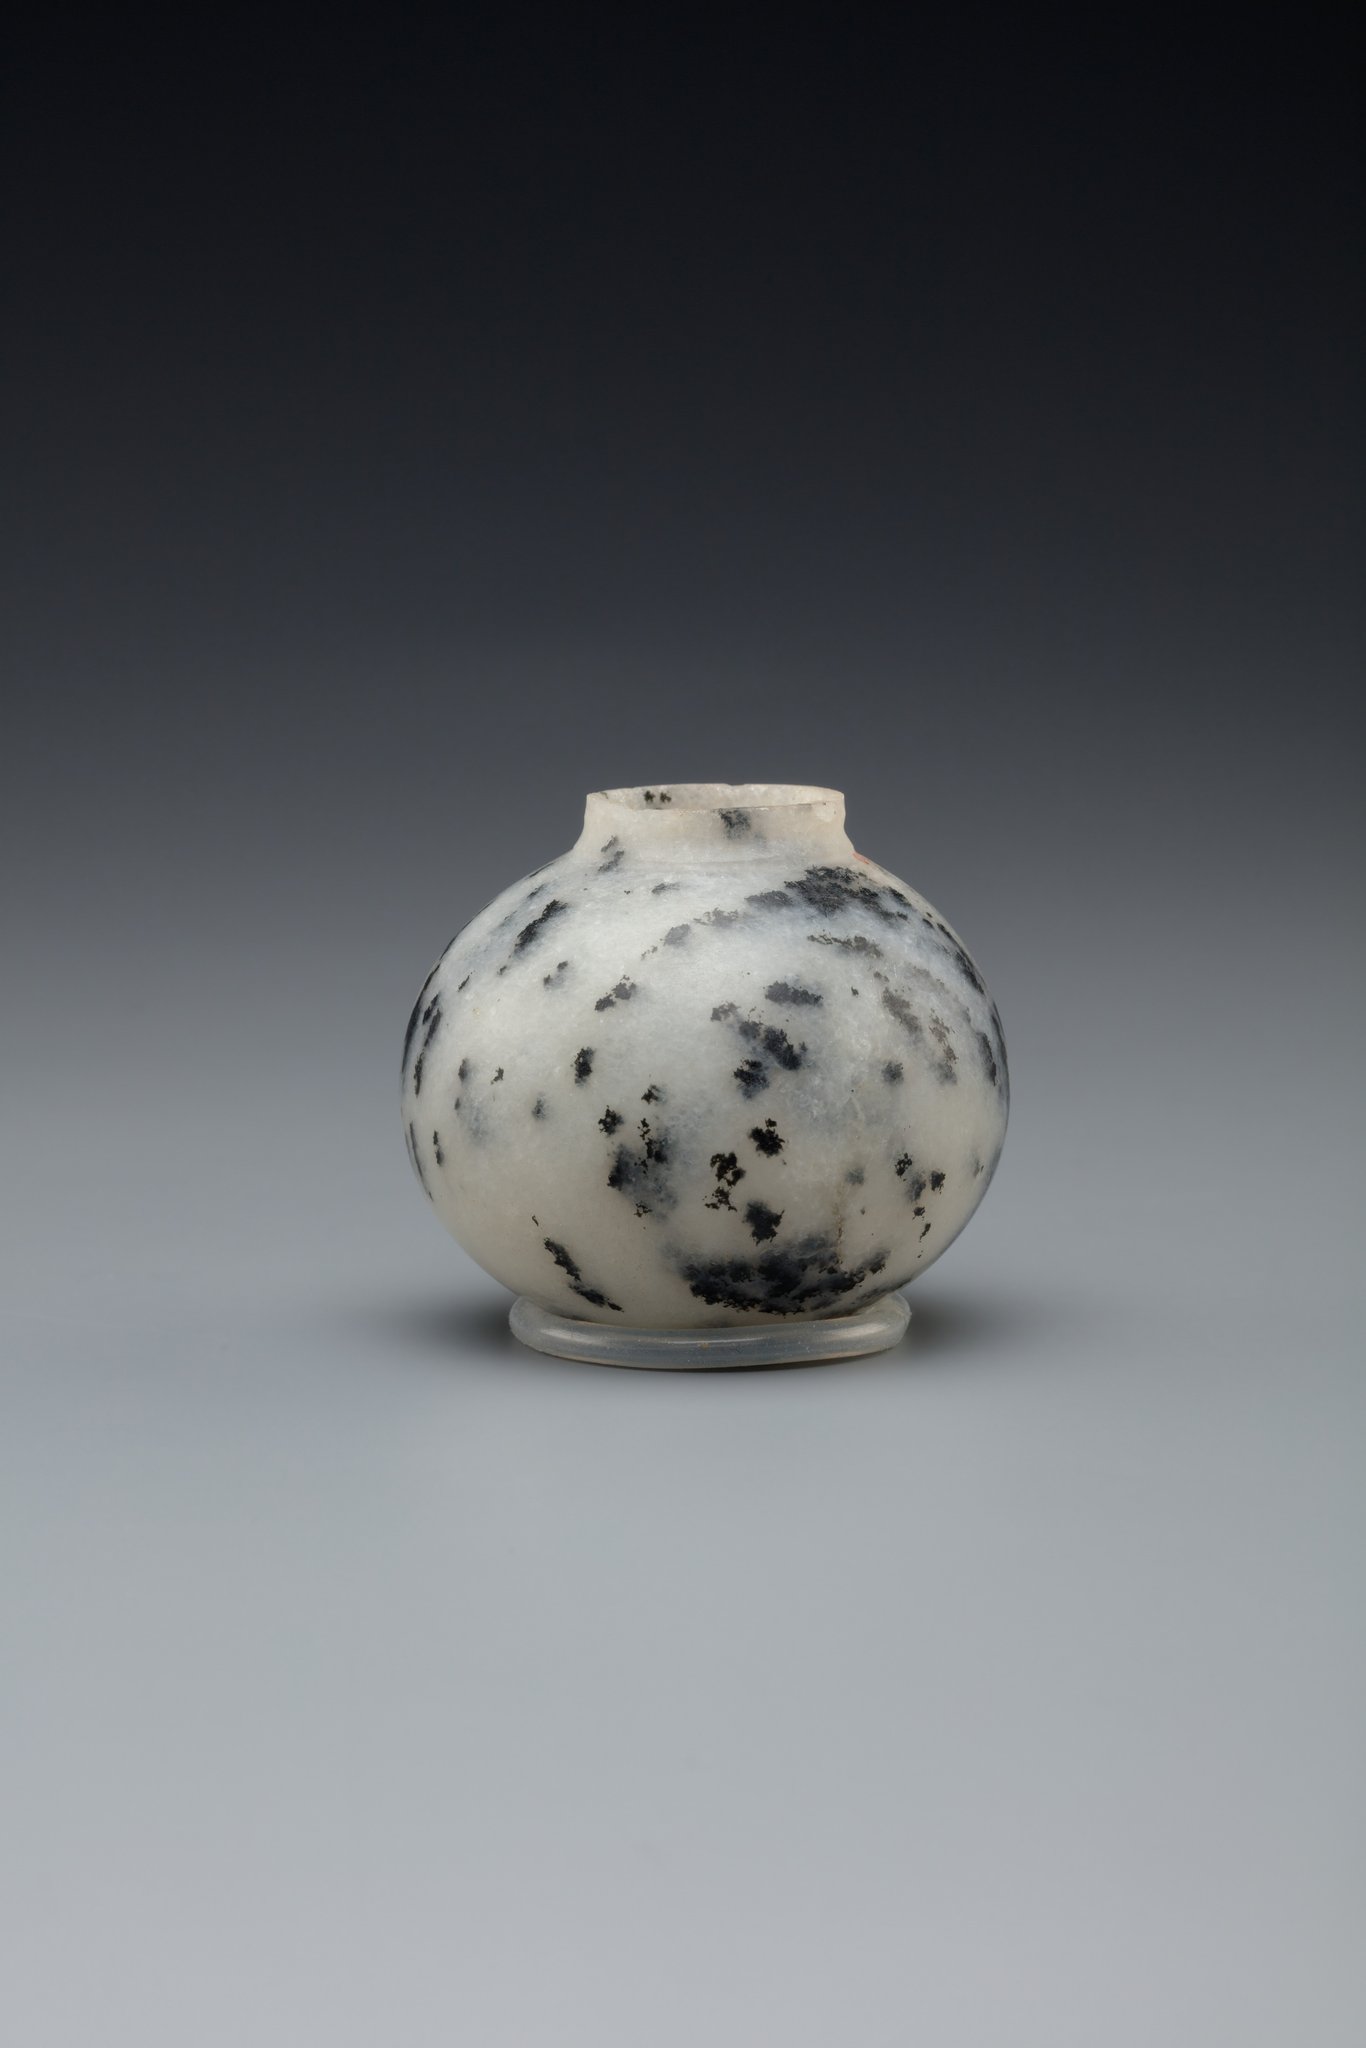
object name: pot, nw pot, miniature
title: Miniature "nw" pot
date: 2465-2150 BCE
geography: egypt